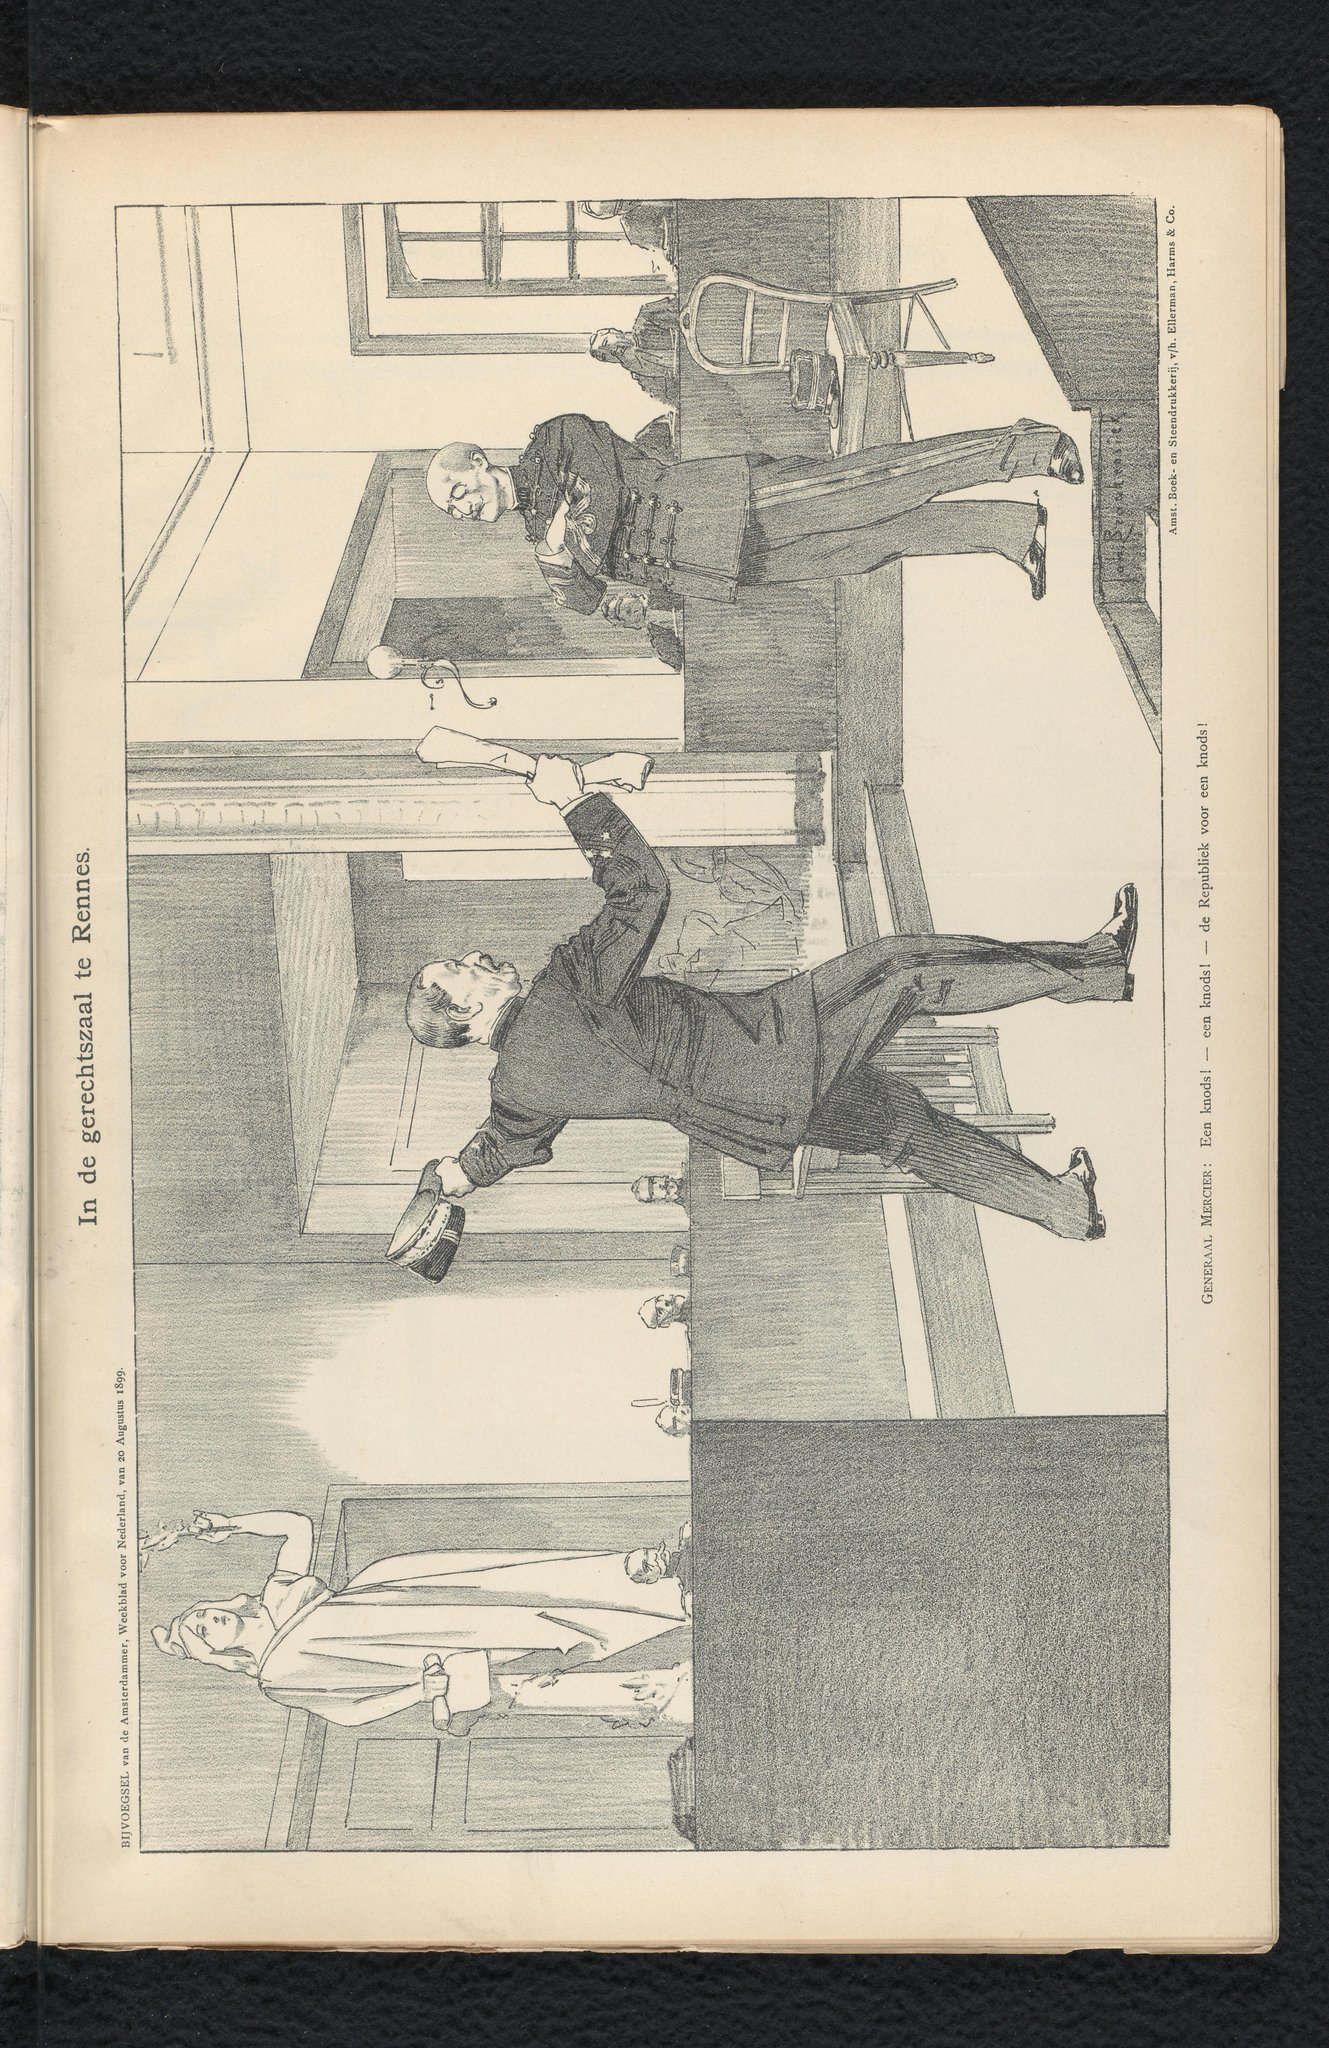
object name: cartoon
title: In de gerechtszaal te Rennes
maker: johan braakensiek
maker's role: draughtsman, print maker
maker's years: 1858-1940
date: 1899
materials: paper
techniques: lithograph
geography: netherlands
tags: court session (court of justice), political caricatures and satires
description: Het proces tijdens de Dreyfusaffaire in de rechtszaal in Rennes. Generaal Mercier, minister van Oorlog, maakt zich boos tegenover Dreyfus. Links een standbeeld van Marianne, de Franse maagd.